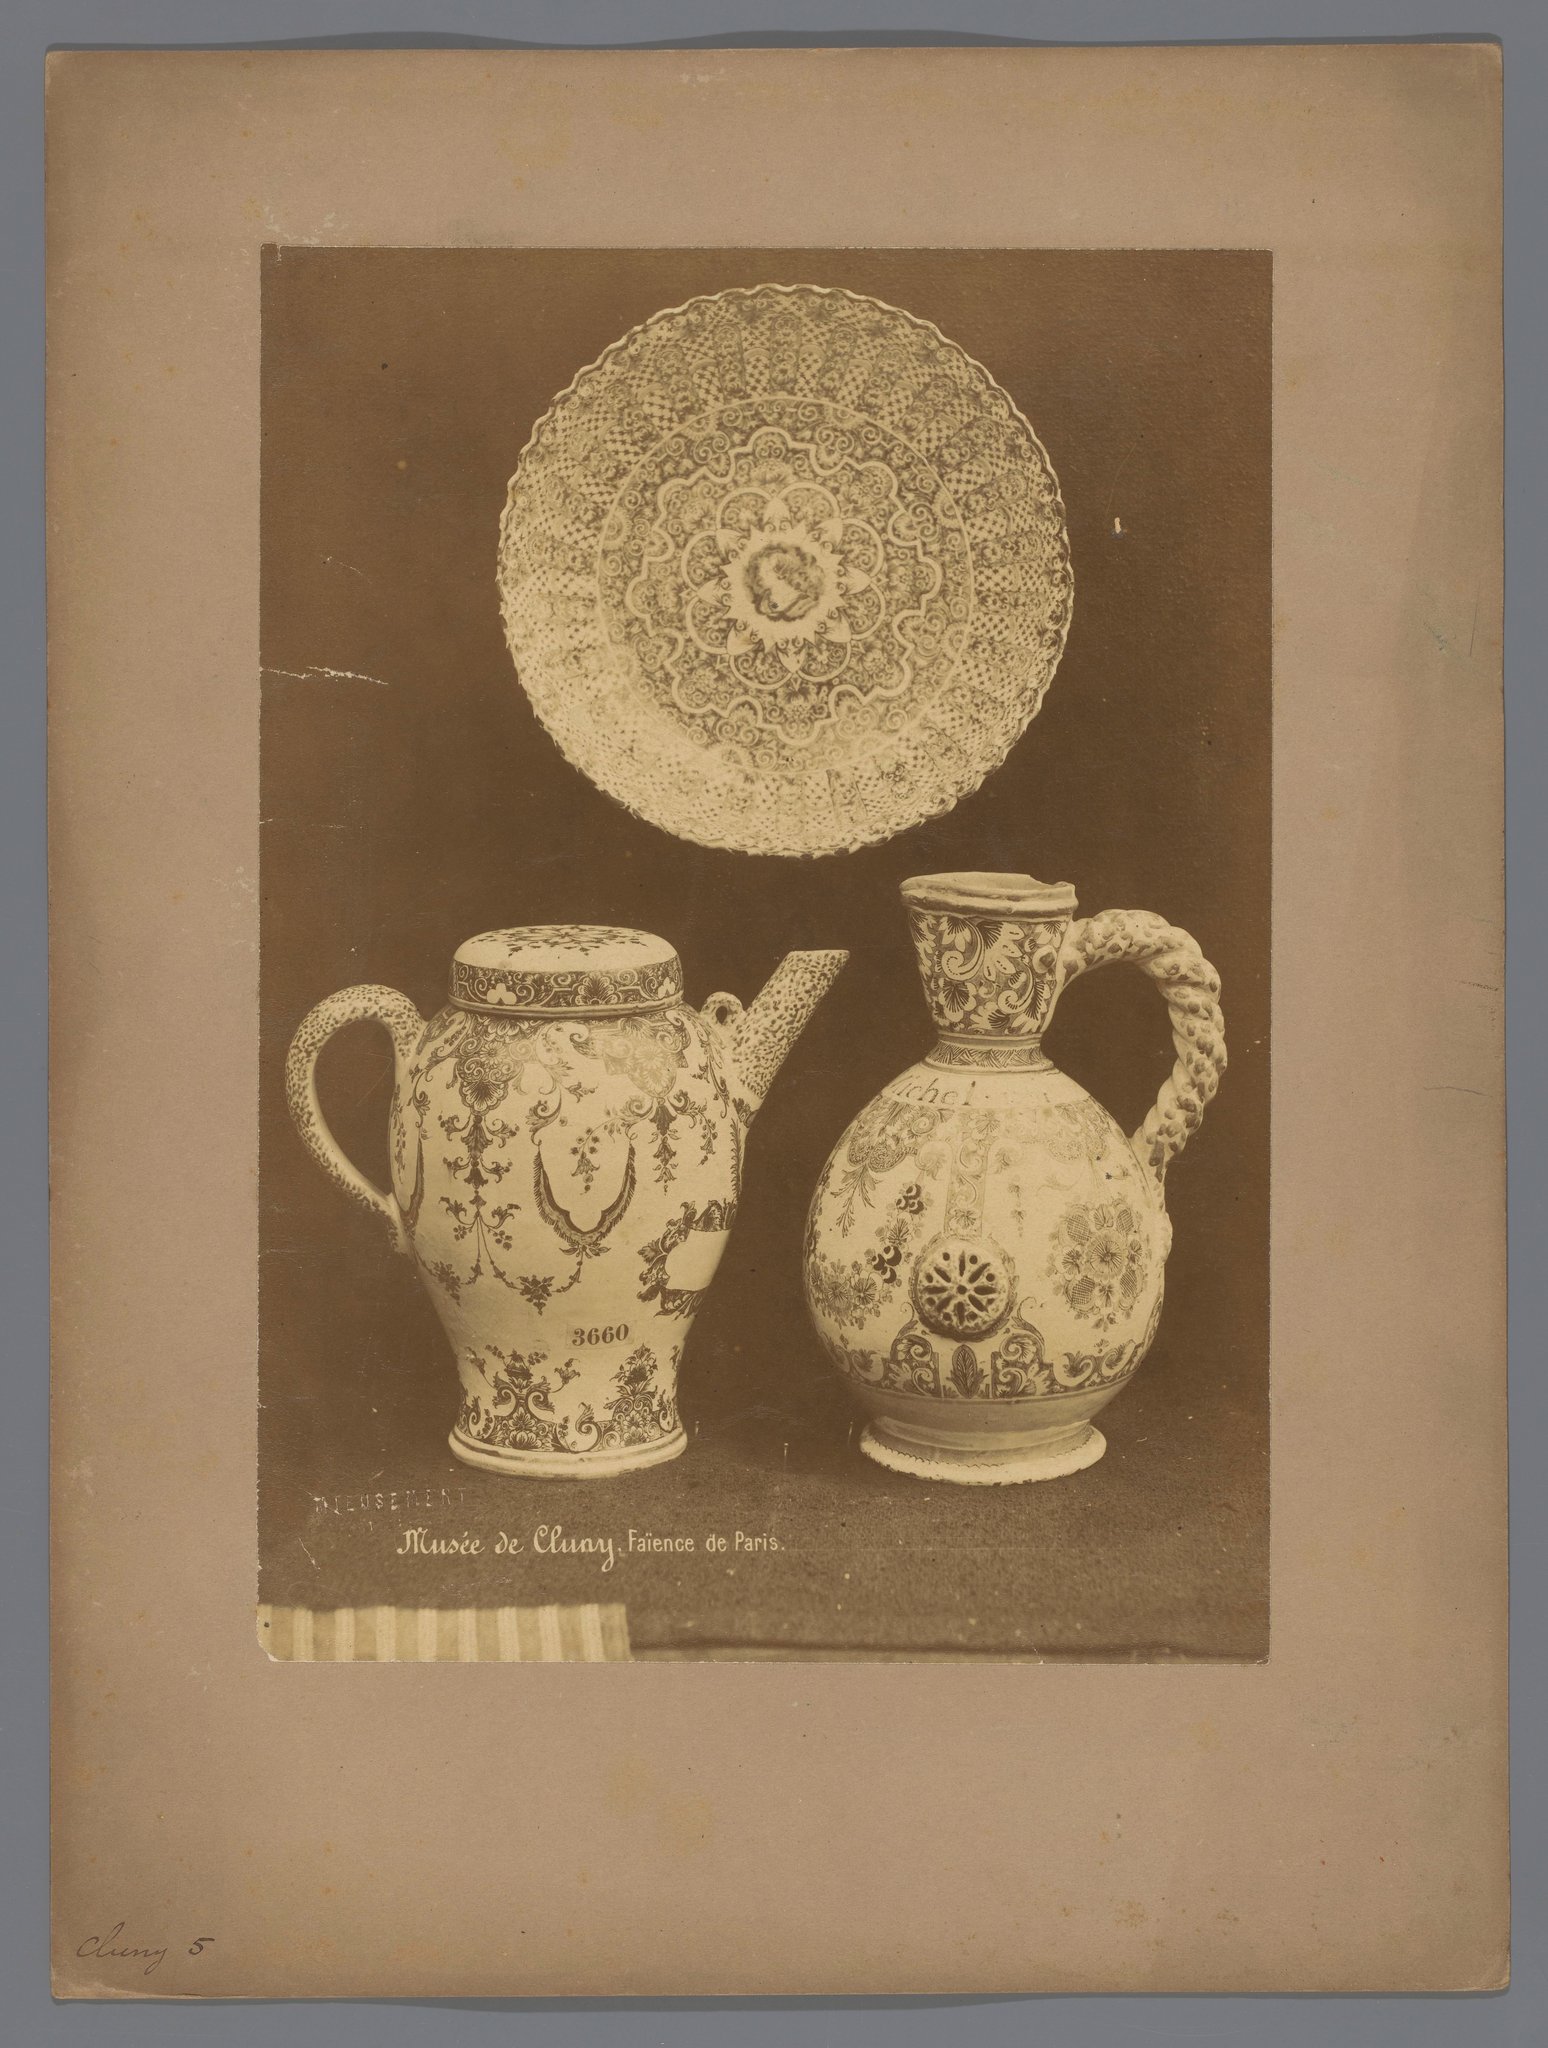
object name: photograph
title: Versierd aardewerk, theepot, karaf en bord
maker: séraphin-médéric mieusement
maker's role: fotograaf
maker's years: 1840-1905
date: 1850-1900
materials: cardboard, photographic support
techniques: albumen print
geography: paris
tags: tea-pot; samovar, container of ceramics: jar, jug, pot, vase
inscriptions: collector's mark: ‘Rijks-normaalschool voor teekenonderwijzers Amsterdam’ Lugt 3937, workshop stamp: ‘Mieusement/ Photographe’, number: ‘Cluny 5’